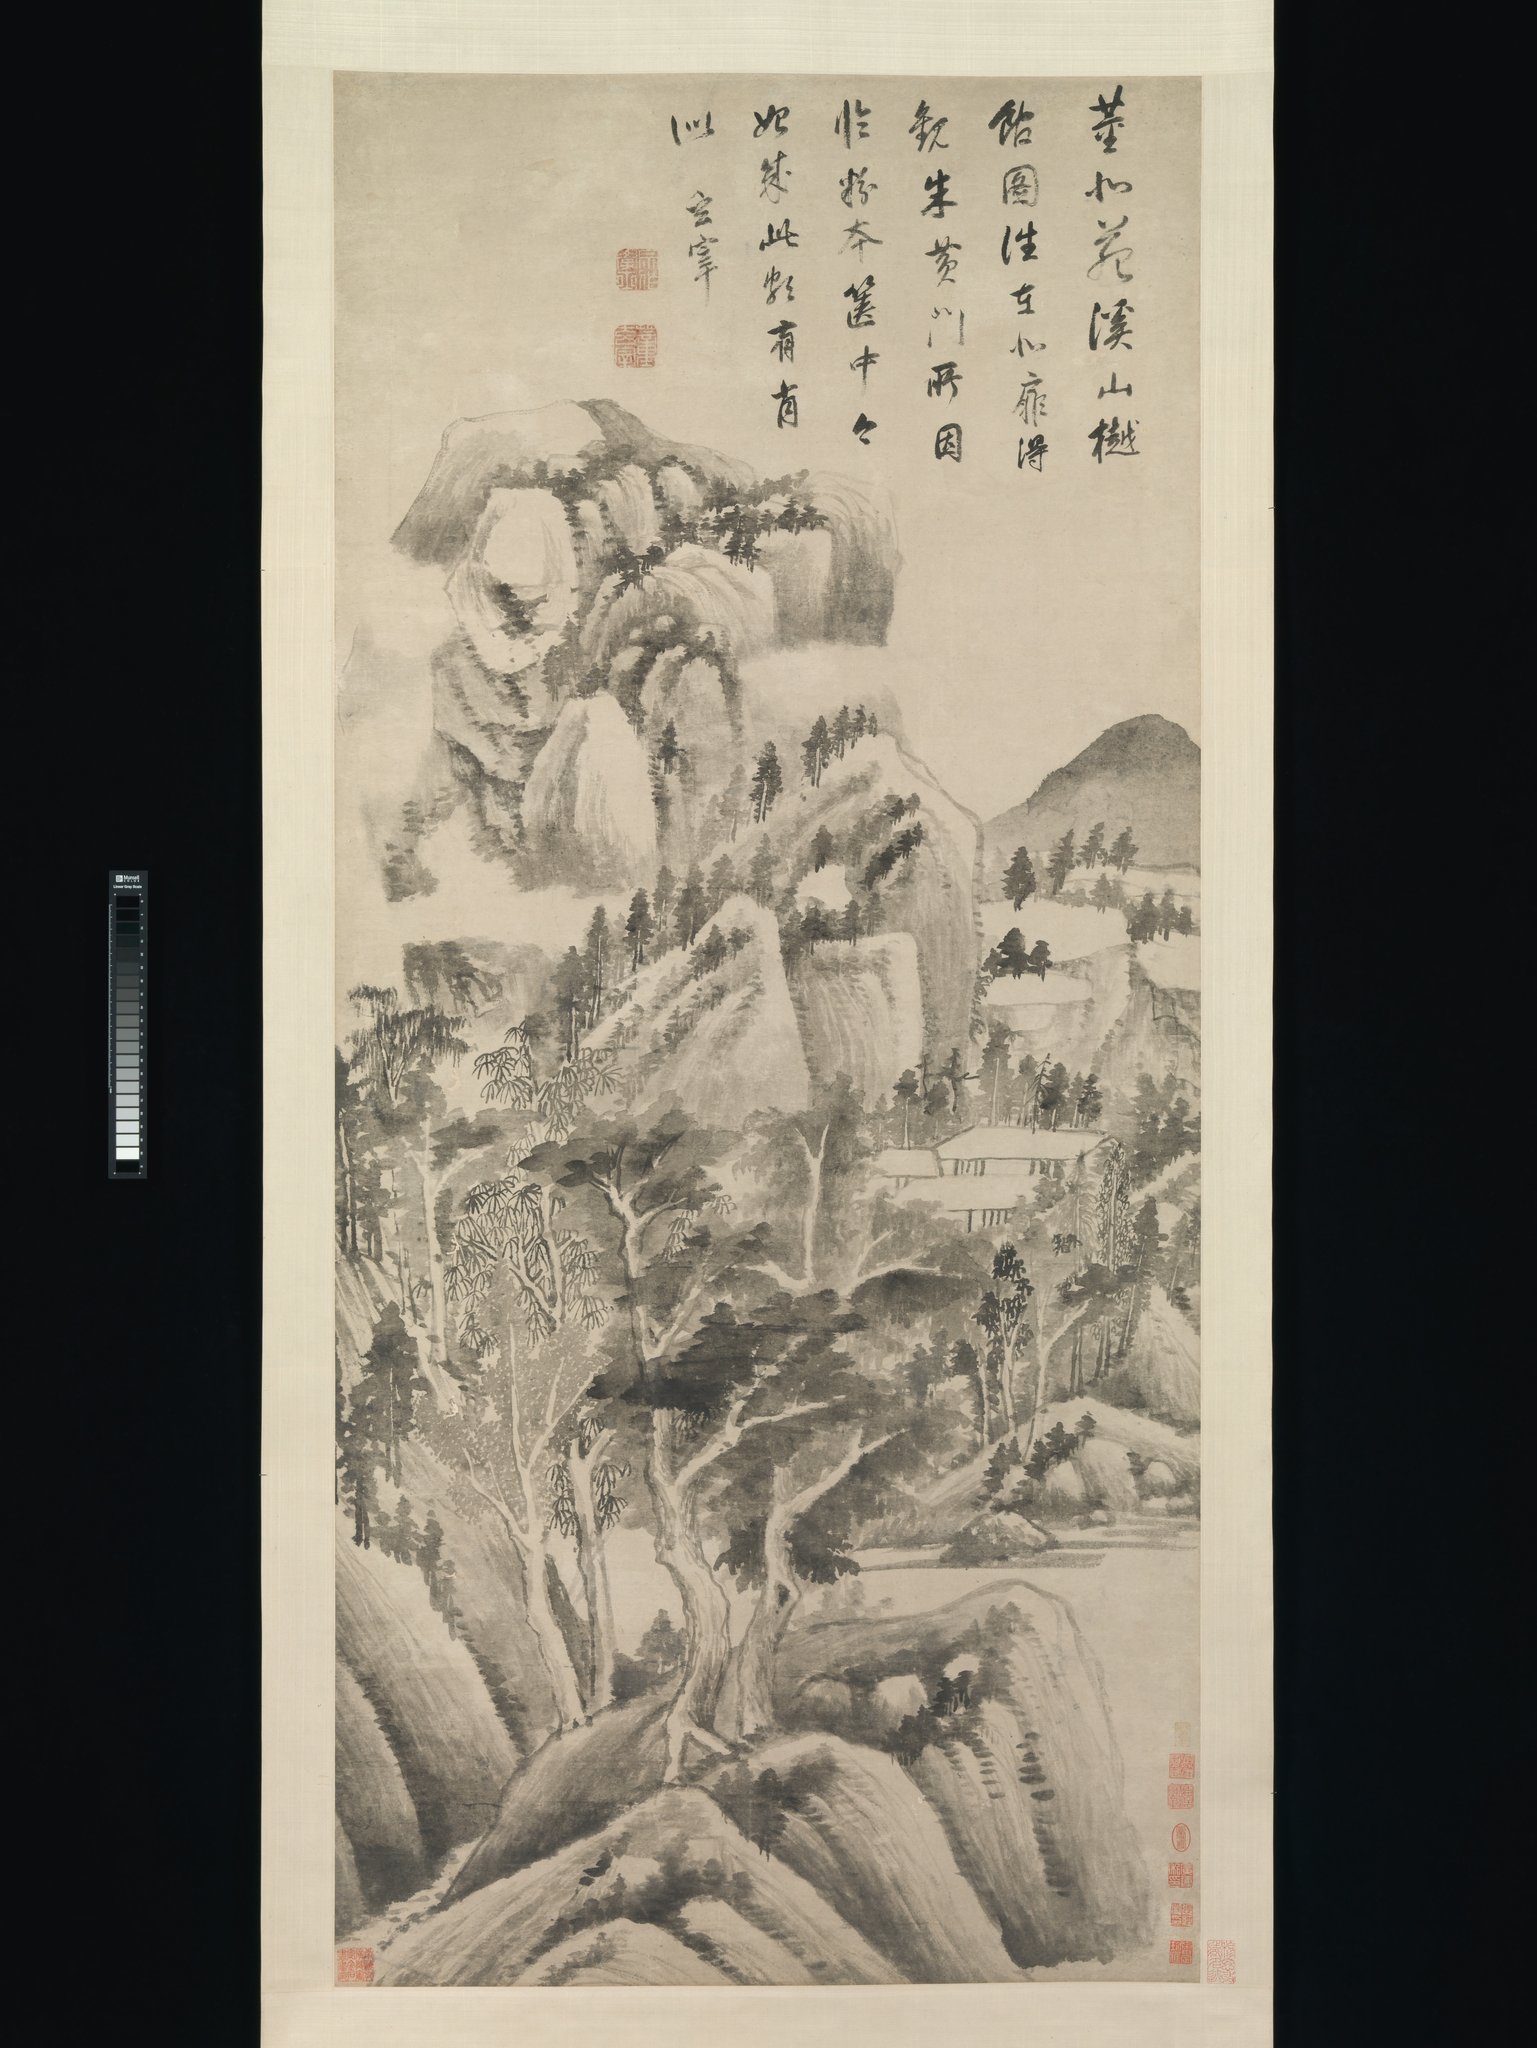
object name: hanging scroll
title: Shaded Dwellings among Streams and Mountains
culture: chinese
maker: dong qichang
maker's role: artist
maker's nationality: chinese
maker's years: 1555-1636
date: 1622-1625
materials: ink, paper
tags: mountains,landscapes,trees